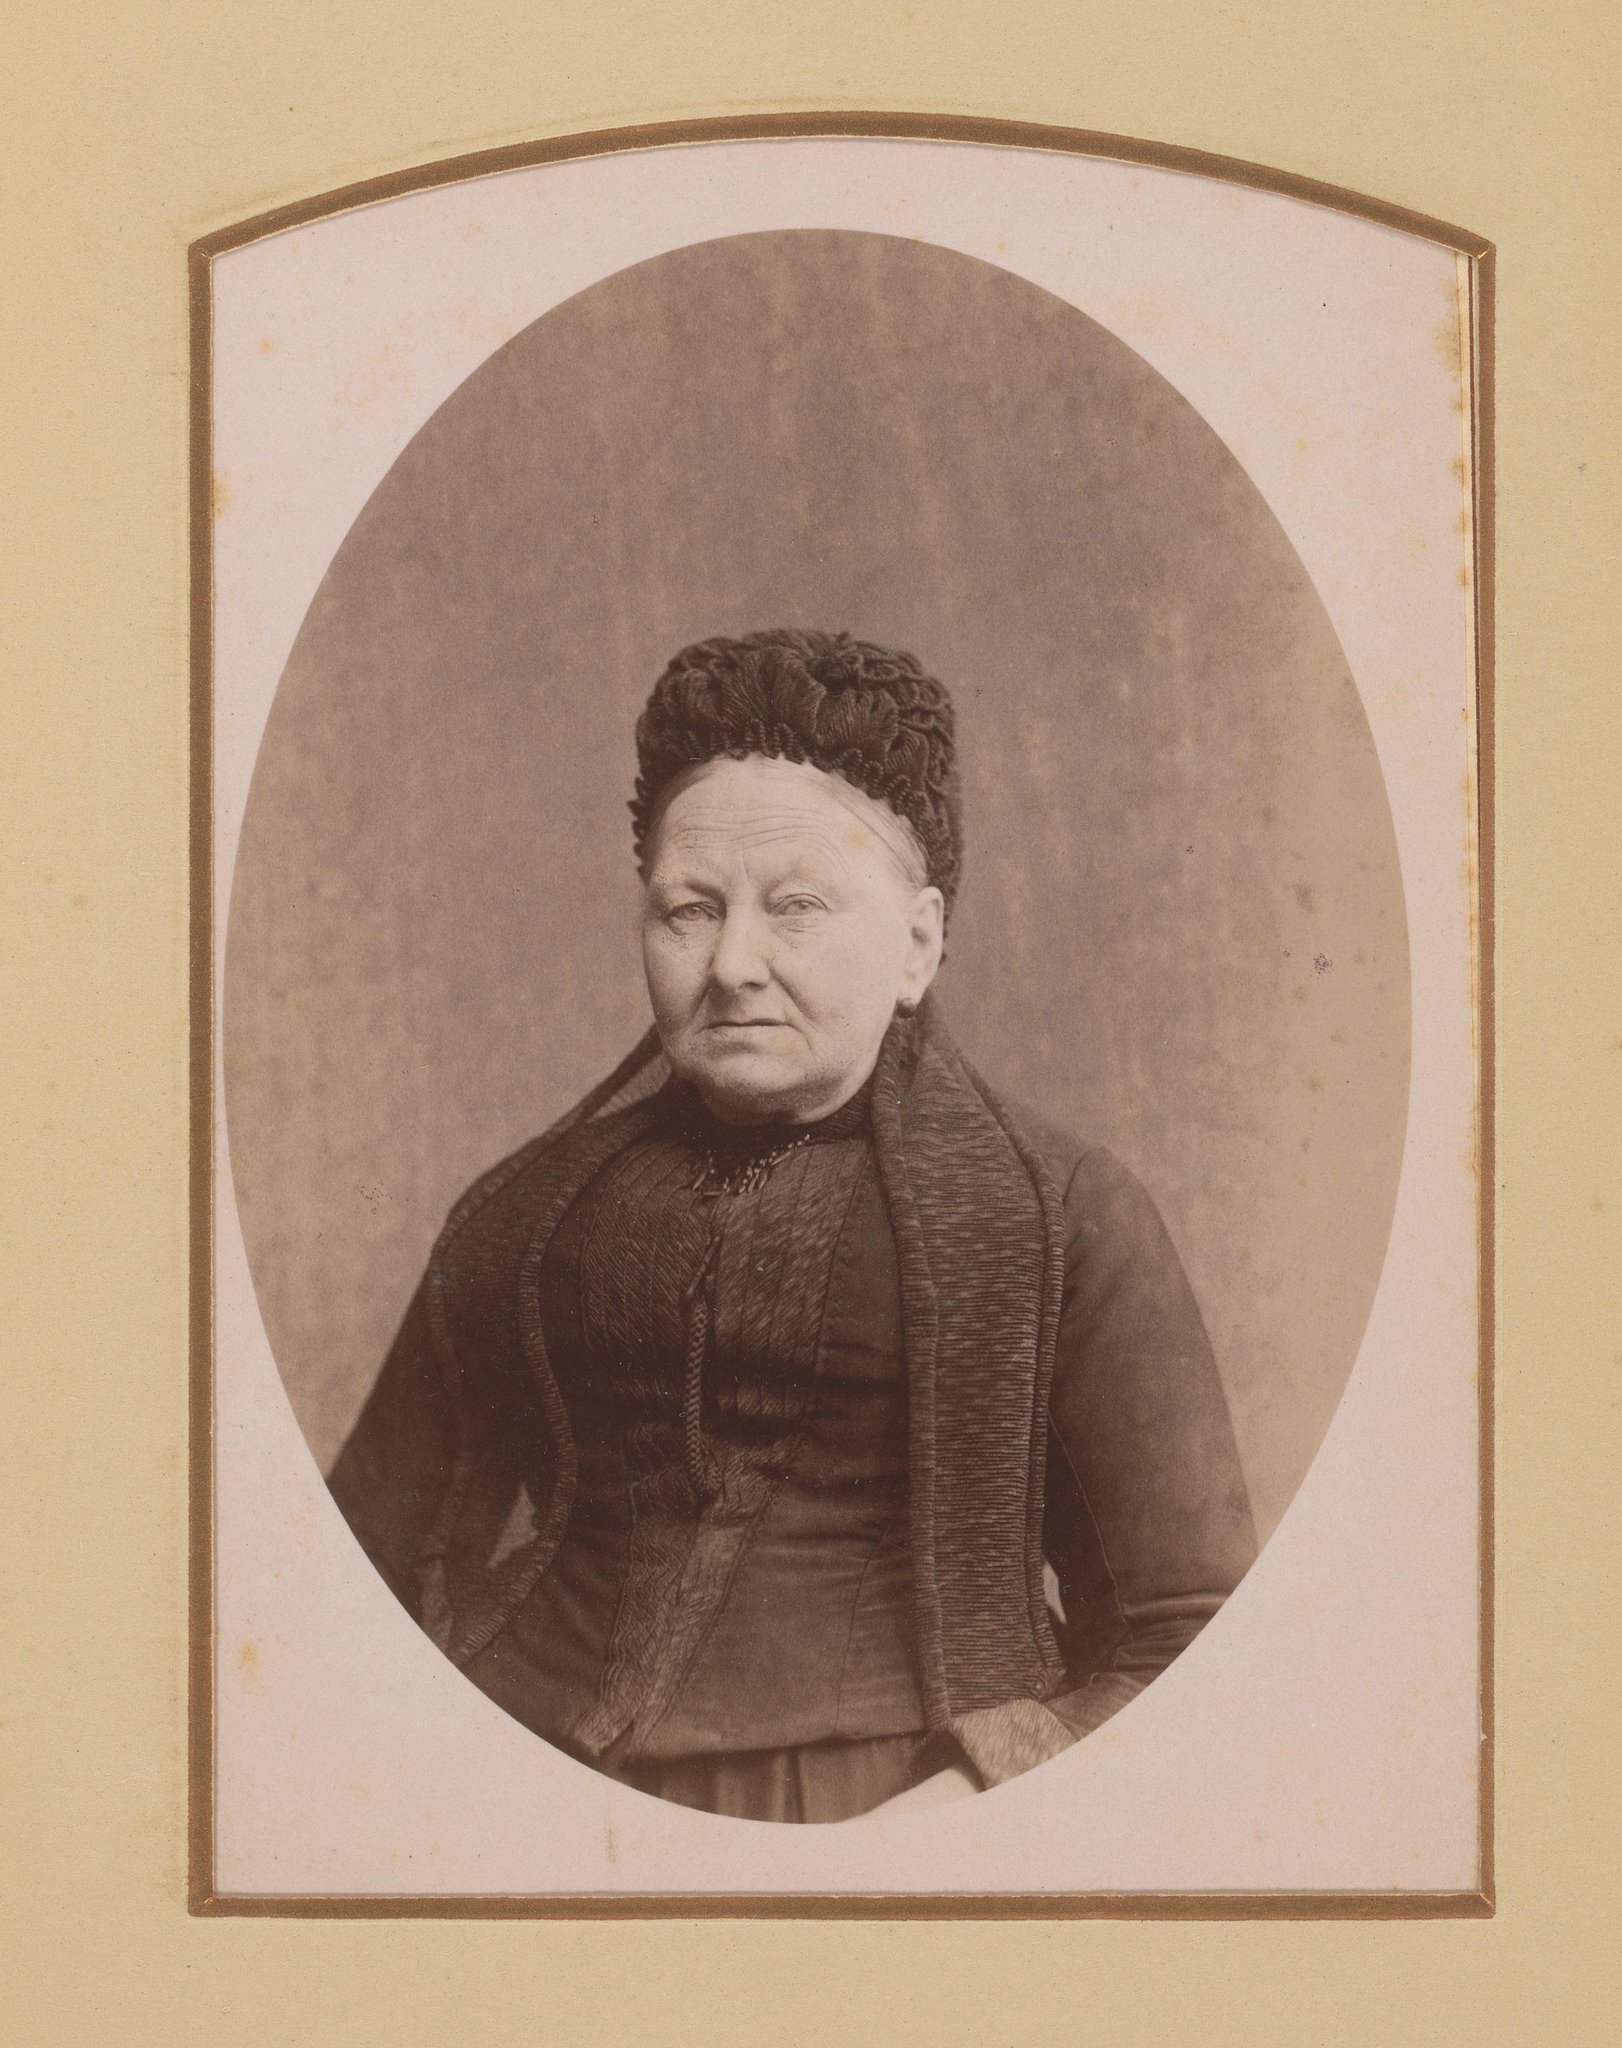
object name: photograph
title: Portret van een zittende vrouw met zwarte muts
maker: louis robert werner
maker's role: fotograaf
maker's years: 1834-1896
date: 1878-1886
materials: cardboard, photographic support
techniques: albumen print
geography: amsterdam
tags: sitting figure - aa - female human figure, historical persons - bb - woman, head-gear: cap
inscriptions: inscription: ‘L. R. Werner/ voorheen P. Carstensen/ Amsterdam/ Nieuwendijk H. 150./ Nabestellingen en Vergrootingen, ook van anderen Portretten,/ kunnen iederen tijd geleverd worden.’, number: ‘51’